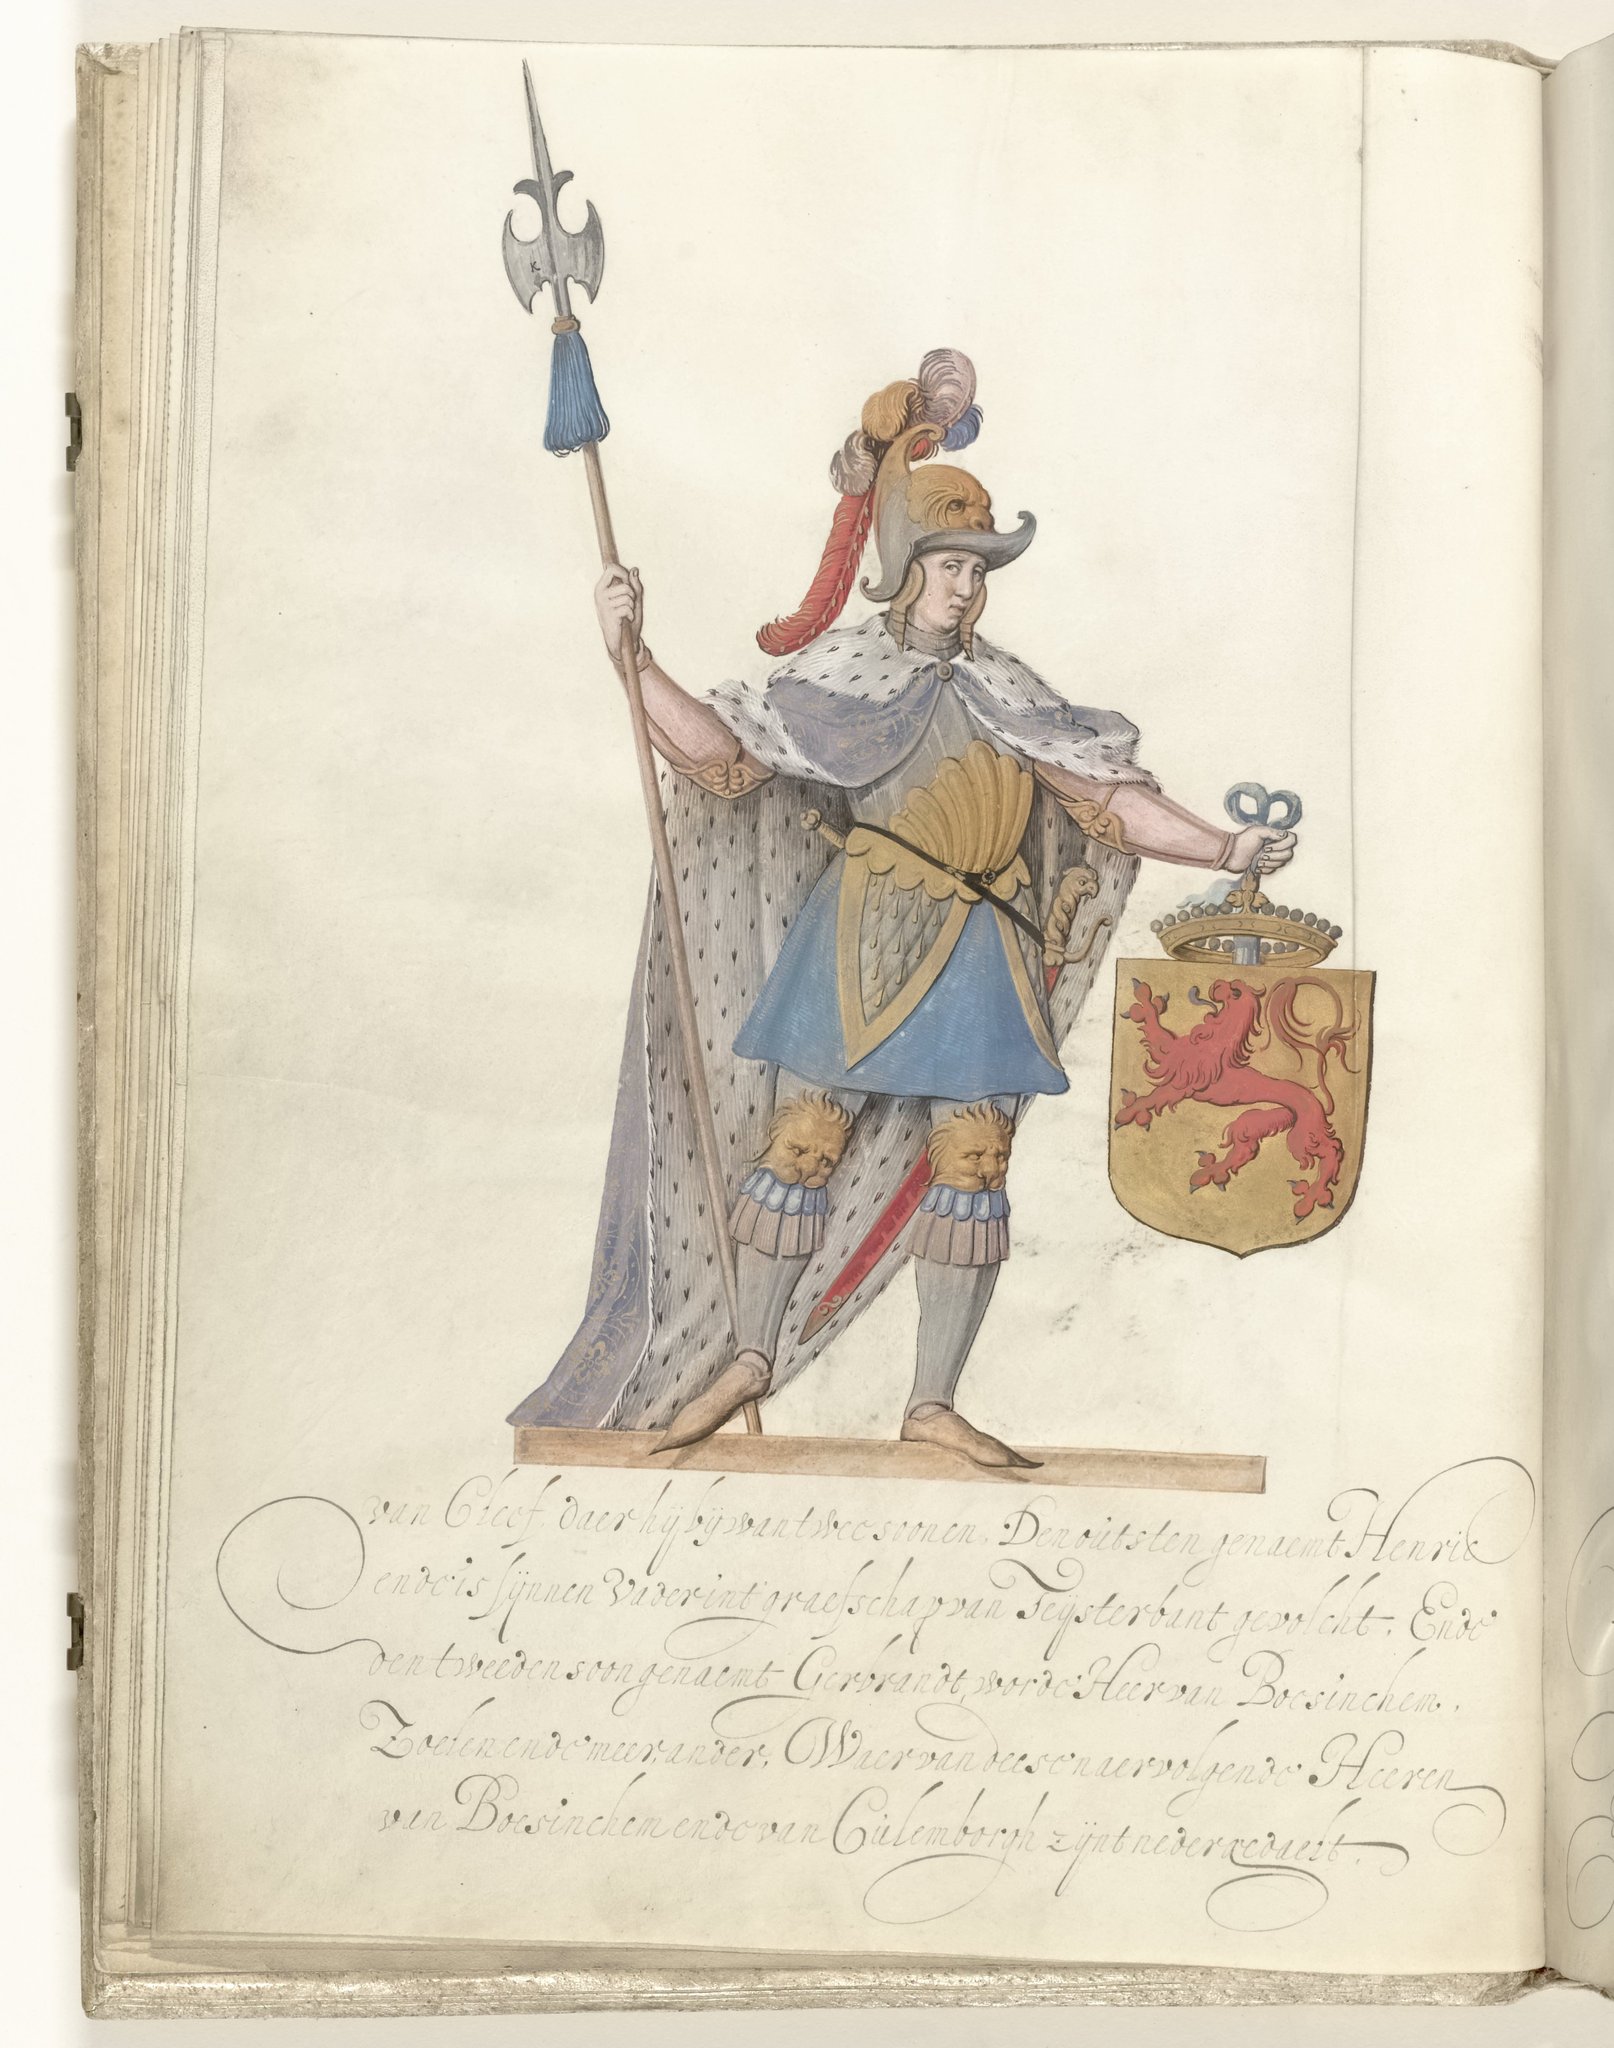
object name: drawing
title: Graaf Waldger van Teisterbant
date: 1590-1593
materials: paint, gouache, ink, parchment, watercolor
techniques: writing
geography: northern netherlands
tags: culemborg, heren en graven van, waldger graaf van teisterbant, graven van teisterbant, culemborg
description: Walgerus (Walgher of Waldger) van Aquitanië, bekender als graaf Waldger van Teisterbant, gehuwd met van de dochter van graaf Boudewijn van Teisterbant. Staande ten voeten uit met een speer in de rechterhand en in de linkerhand het wapen van Aquitanië. Onderdeel van geïllustreerd handschrift met de genealogie van de heren en graven van Culemborg.